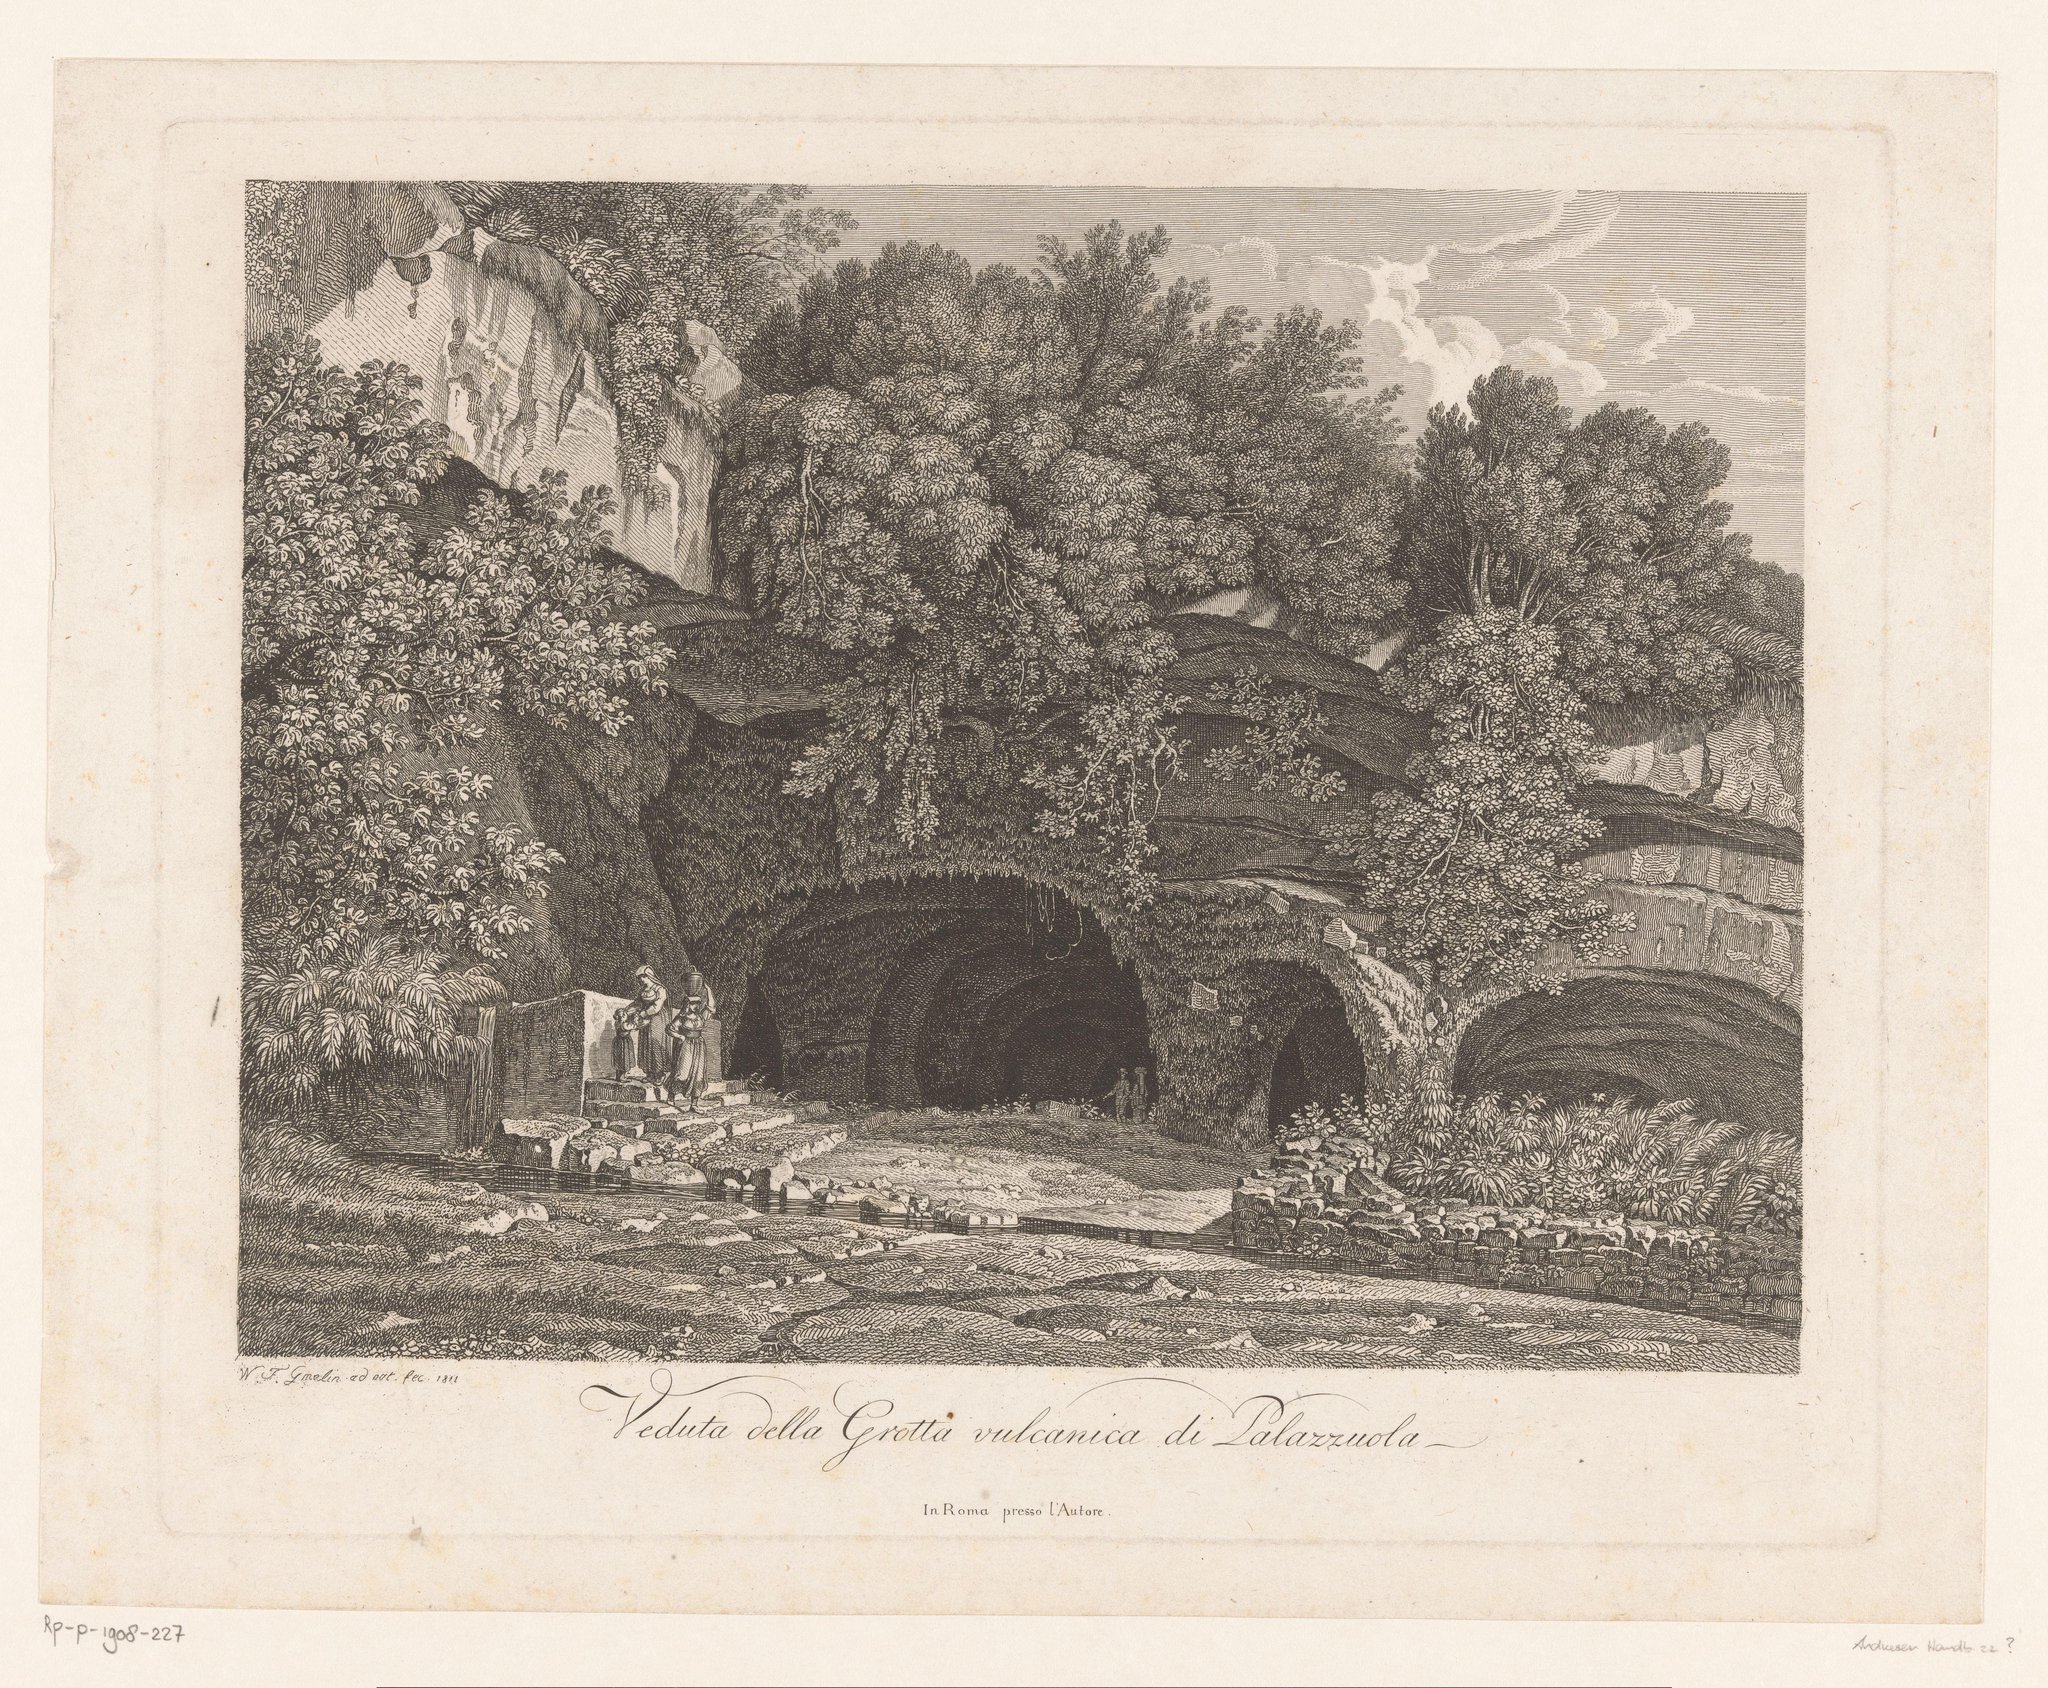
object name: print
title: Veduta della Grotta vulcanica de Palazzuola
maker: wilhelm friedrich gmelin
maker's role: print maker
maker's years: 1760-1820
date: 1811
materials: paper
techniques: etching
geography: rome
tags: cave, grotto, spring, source of river or stream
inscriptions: collector's mark: Lugt 2228